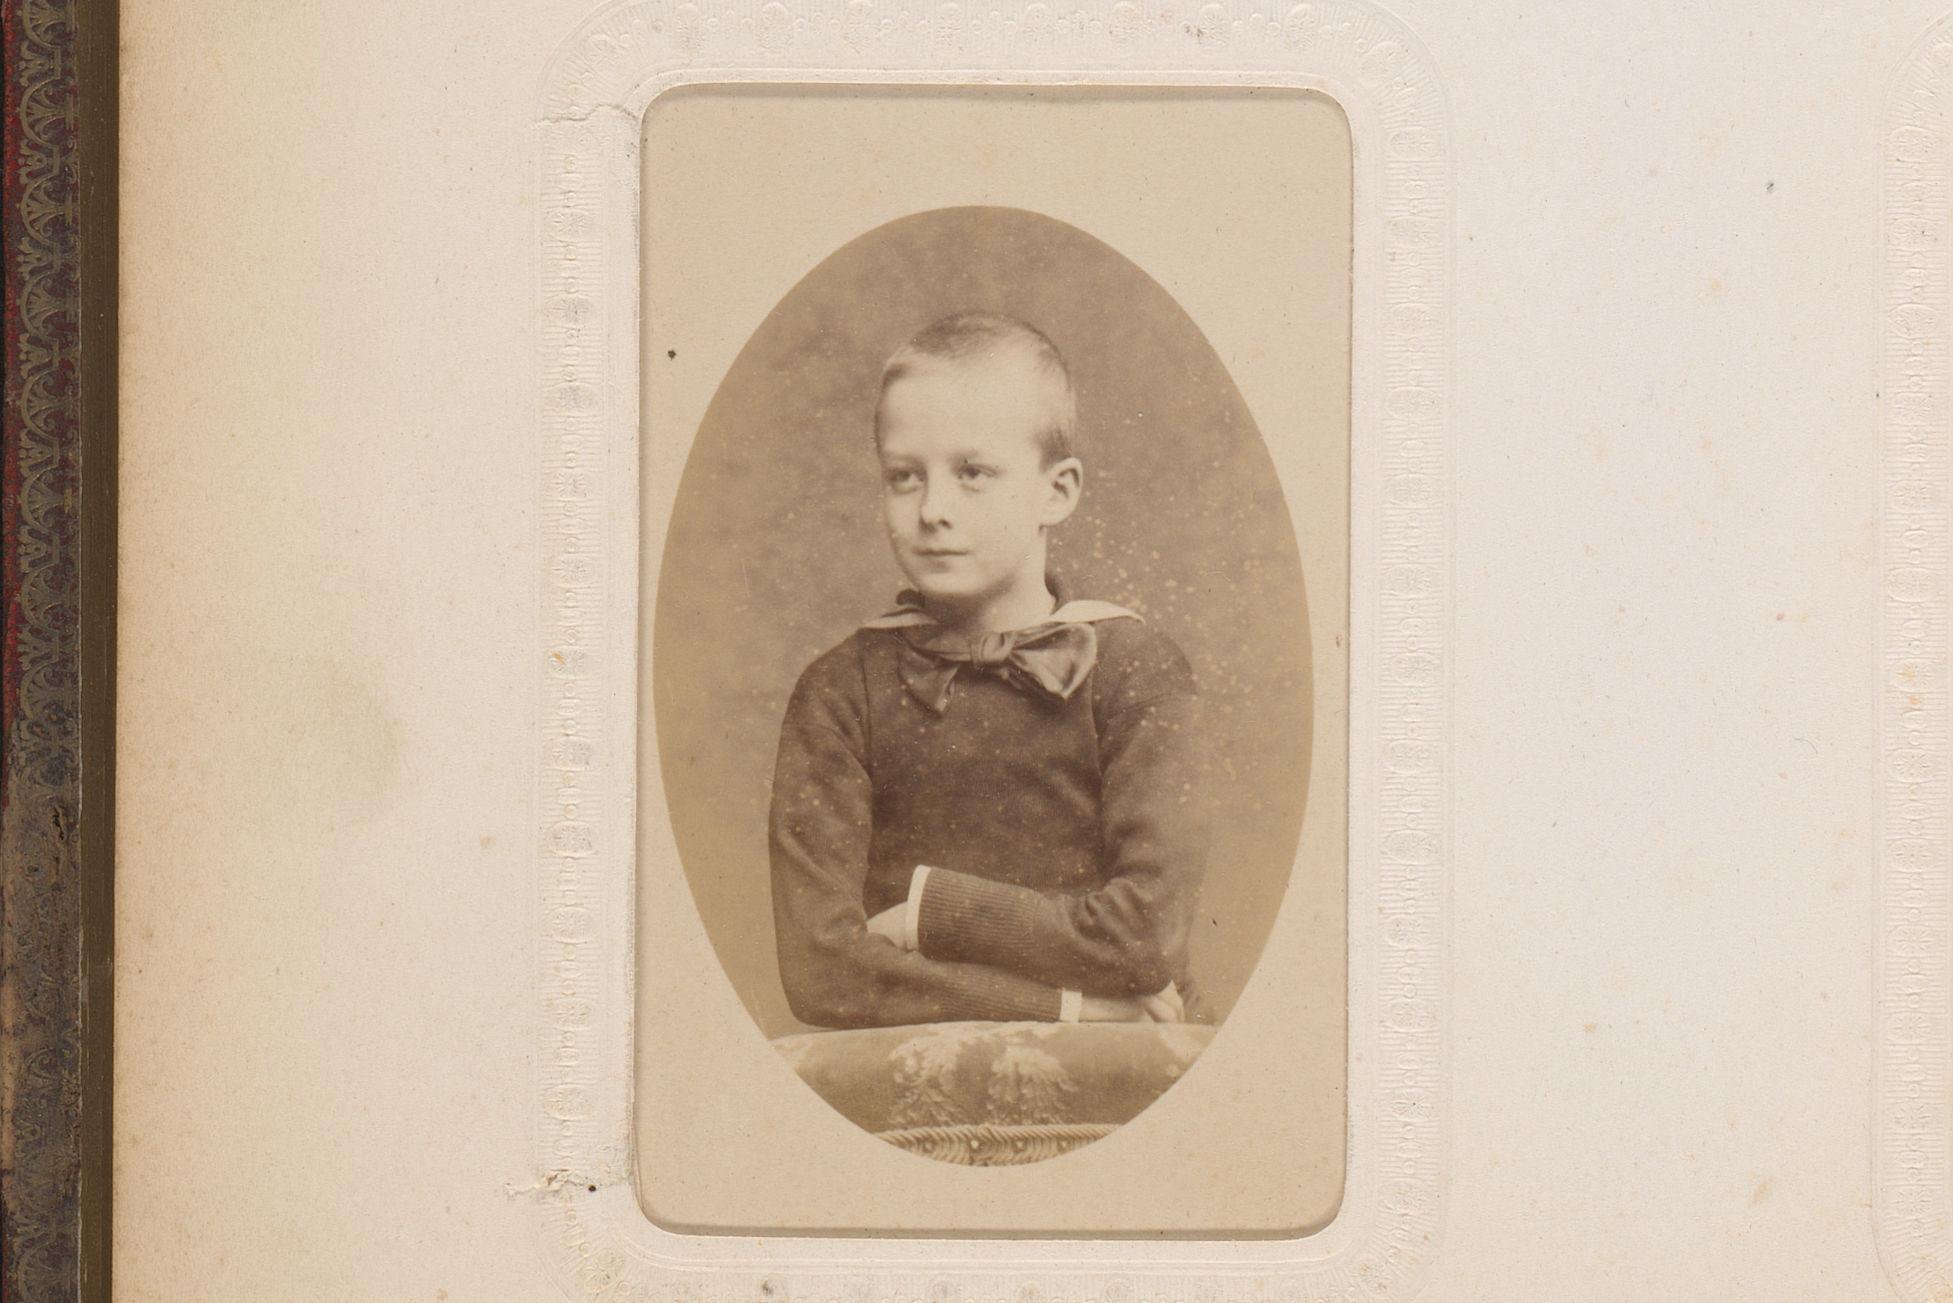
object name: album leaf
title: Portret van een jongen met een hond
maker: Anonymous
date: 1860-1900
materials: cardboard, photographic support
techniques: albumen print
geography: netherlands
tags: boy (child between toddler and youth), historical persons, dog